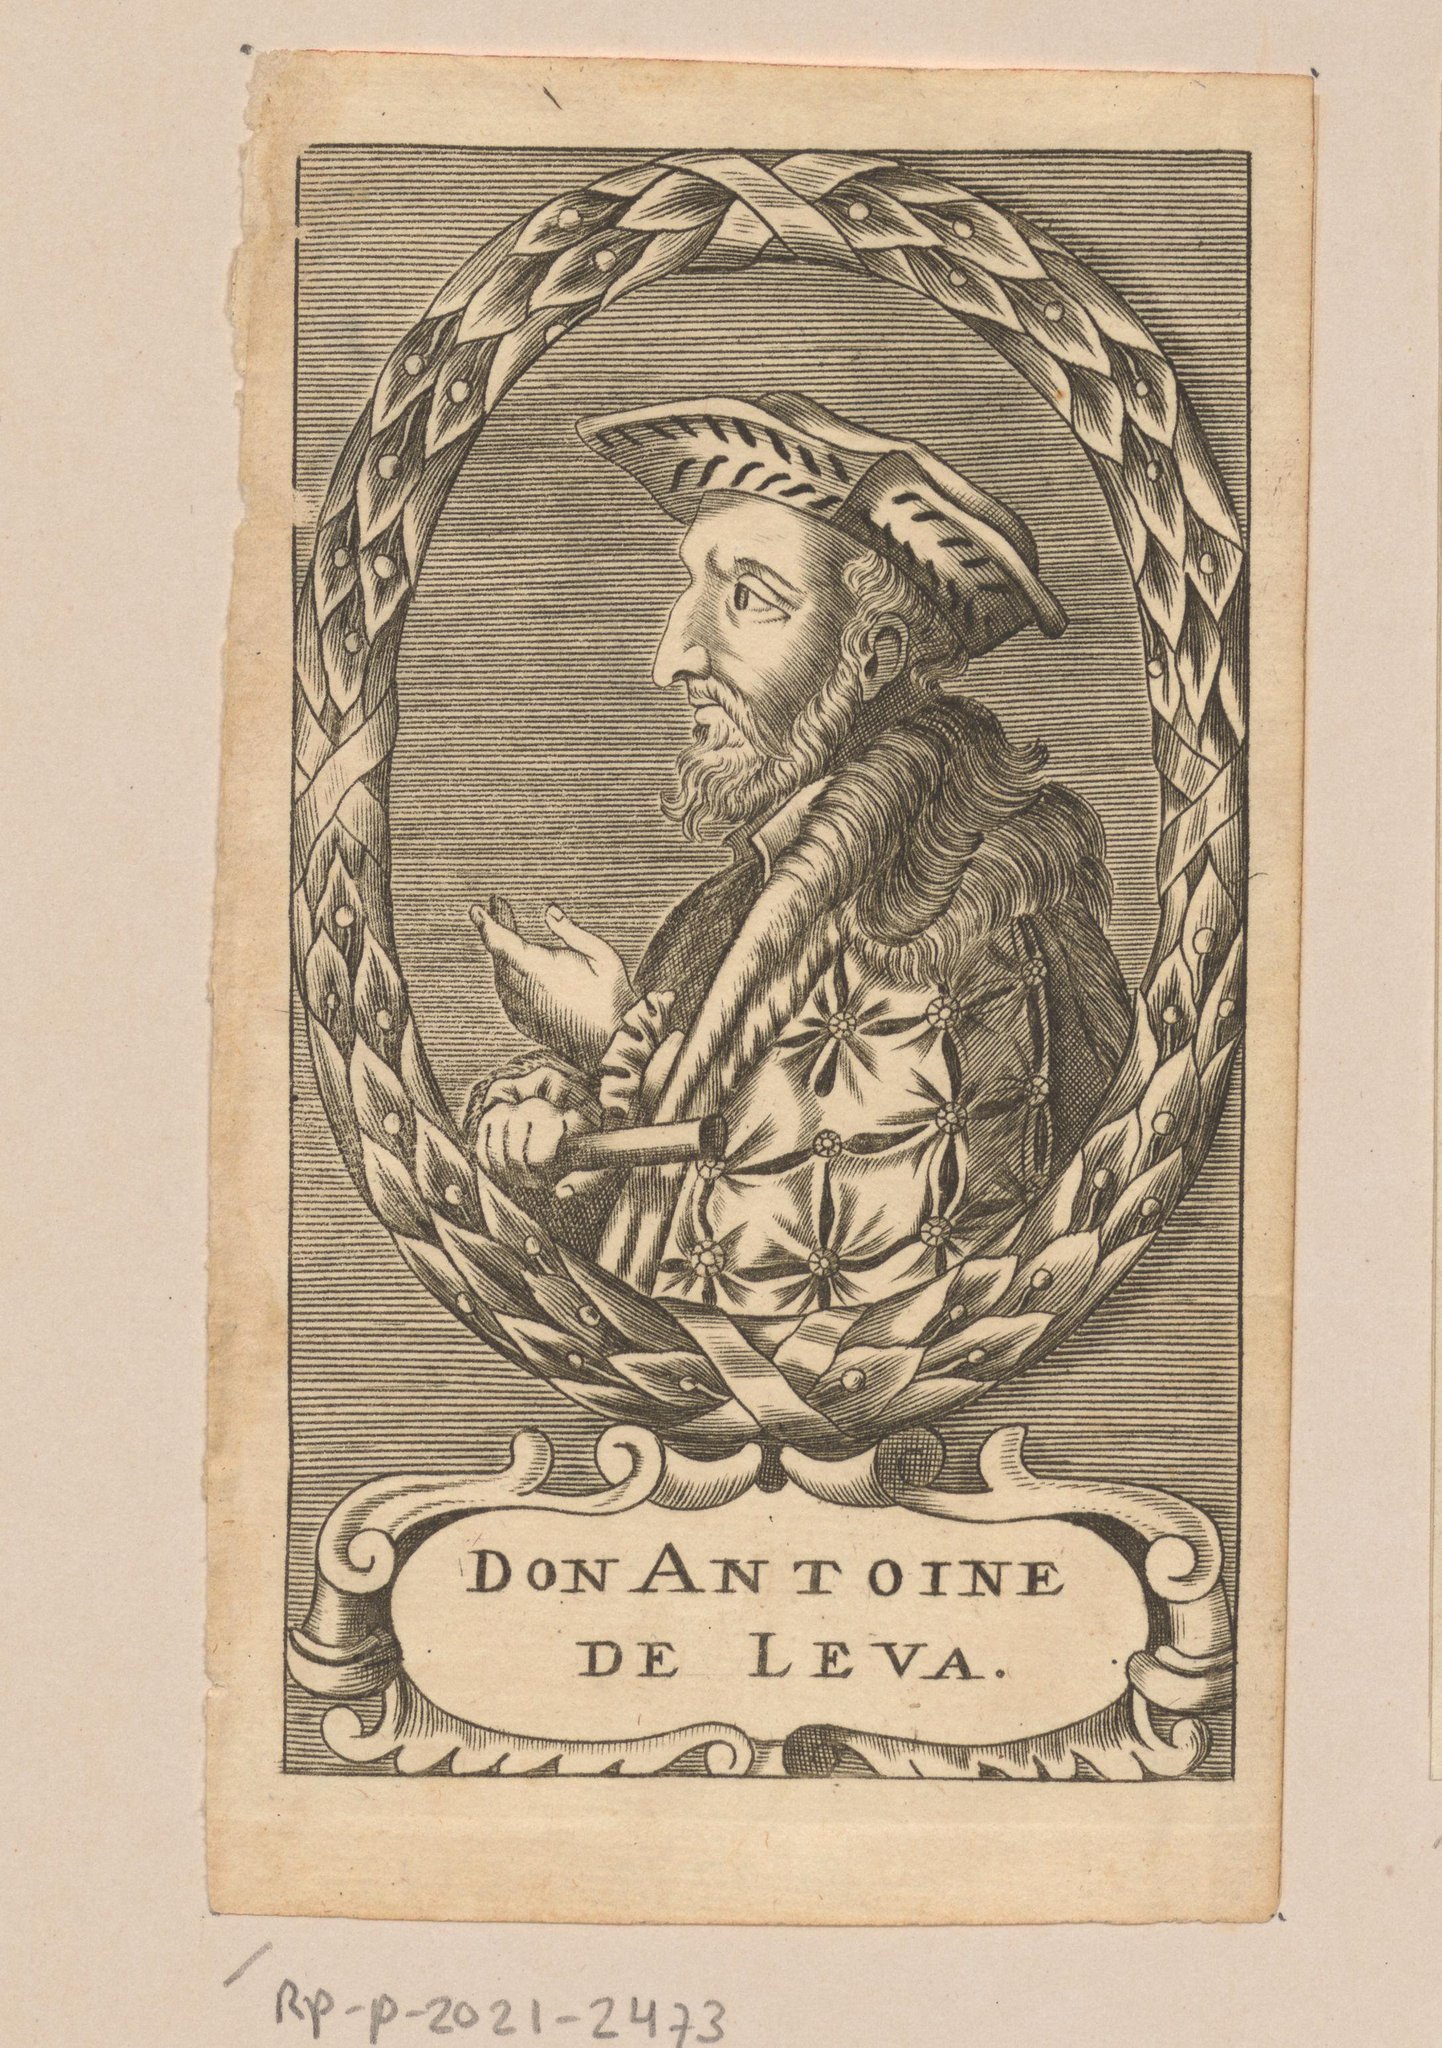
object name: print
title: Portret van Antonio de Leyva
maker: Anonymous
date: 1650-1750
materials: paper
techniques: engraving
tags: ornament ~ medallion, commander-in-chief, general, marshal, historical persons, ornament ~ cartouche